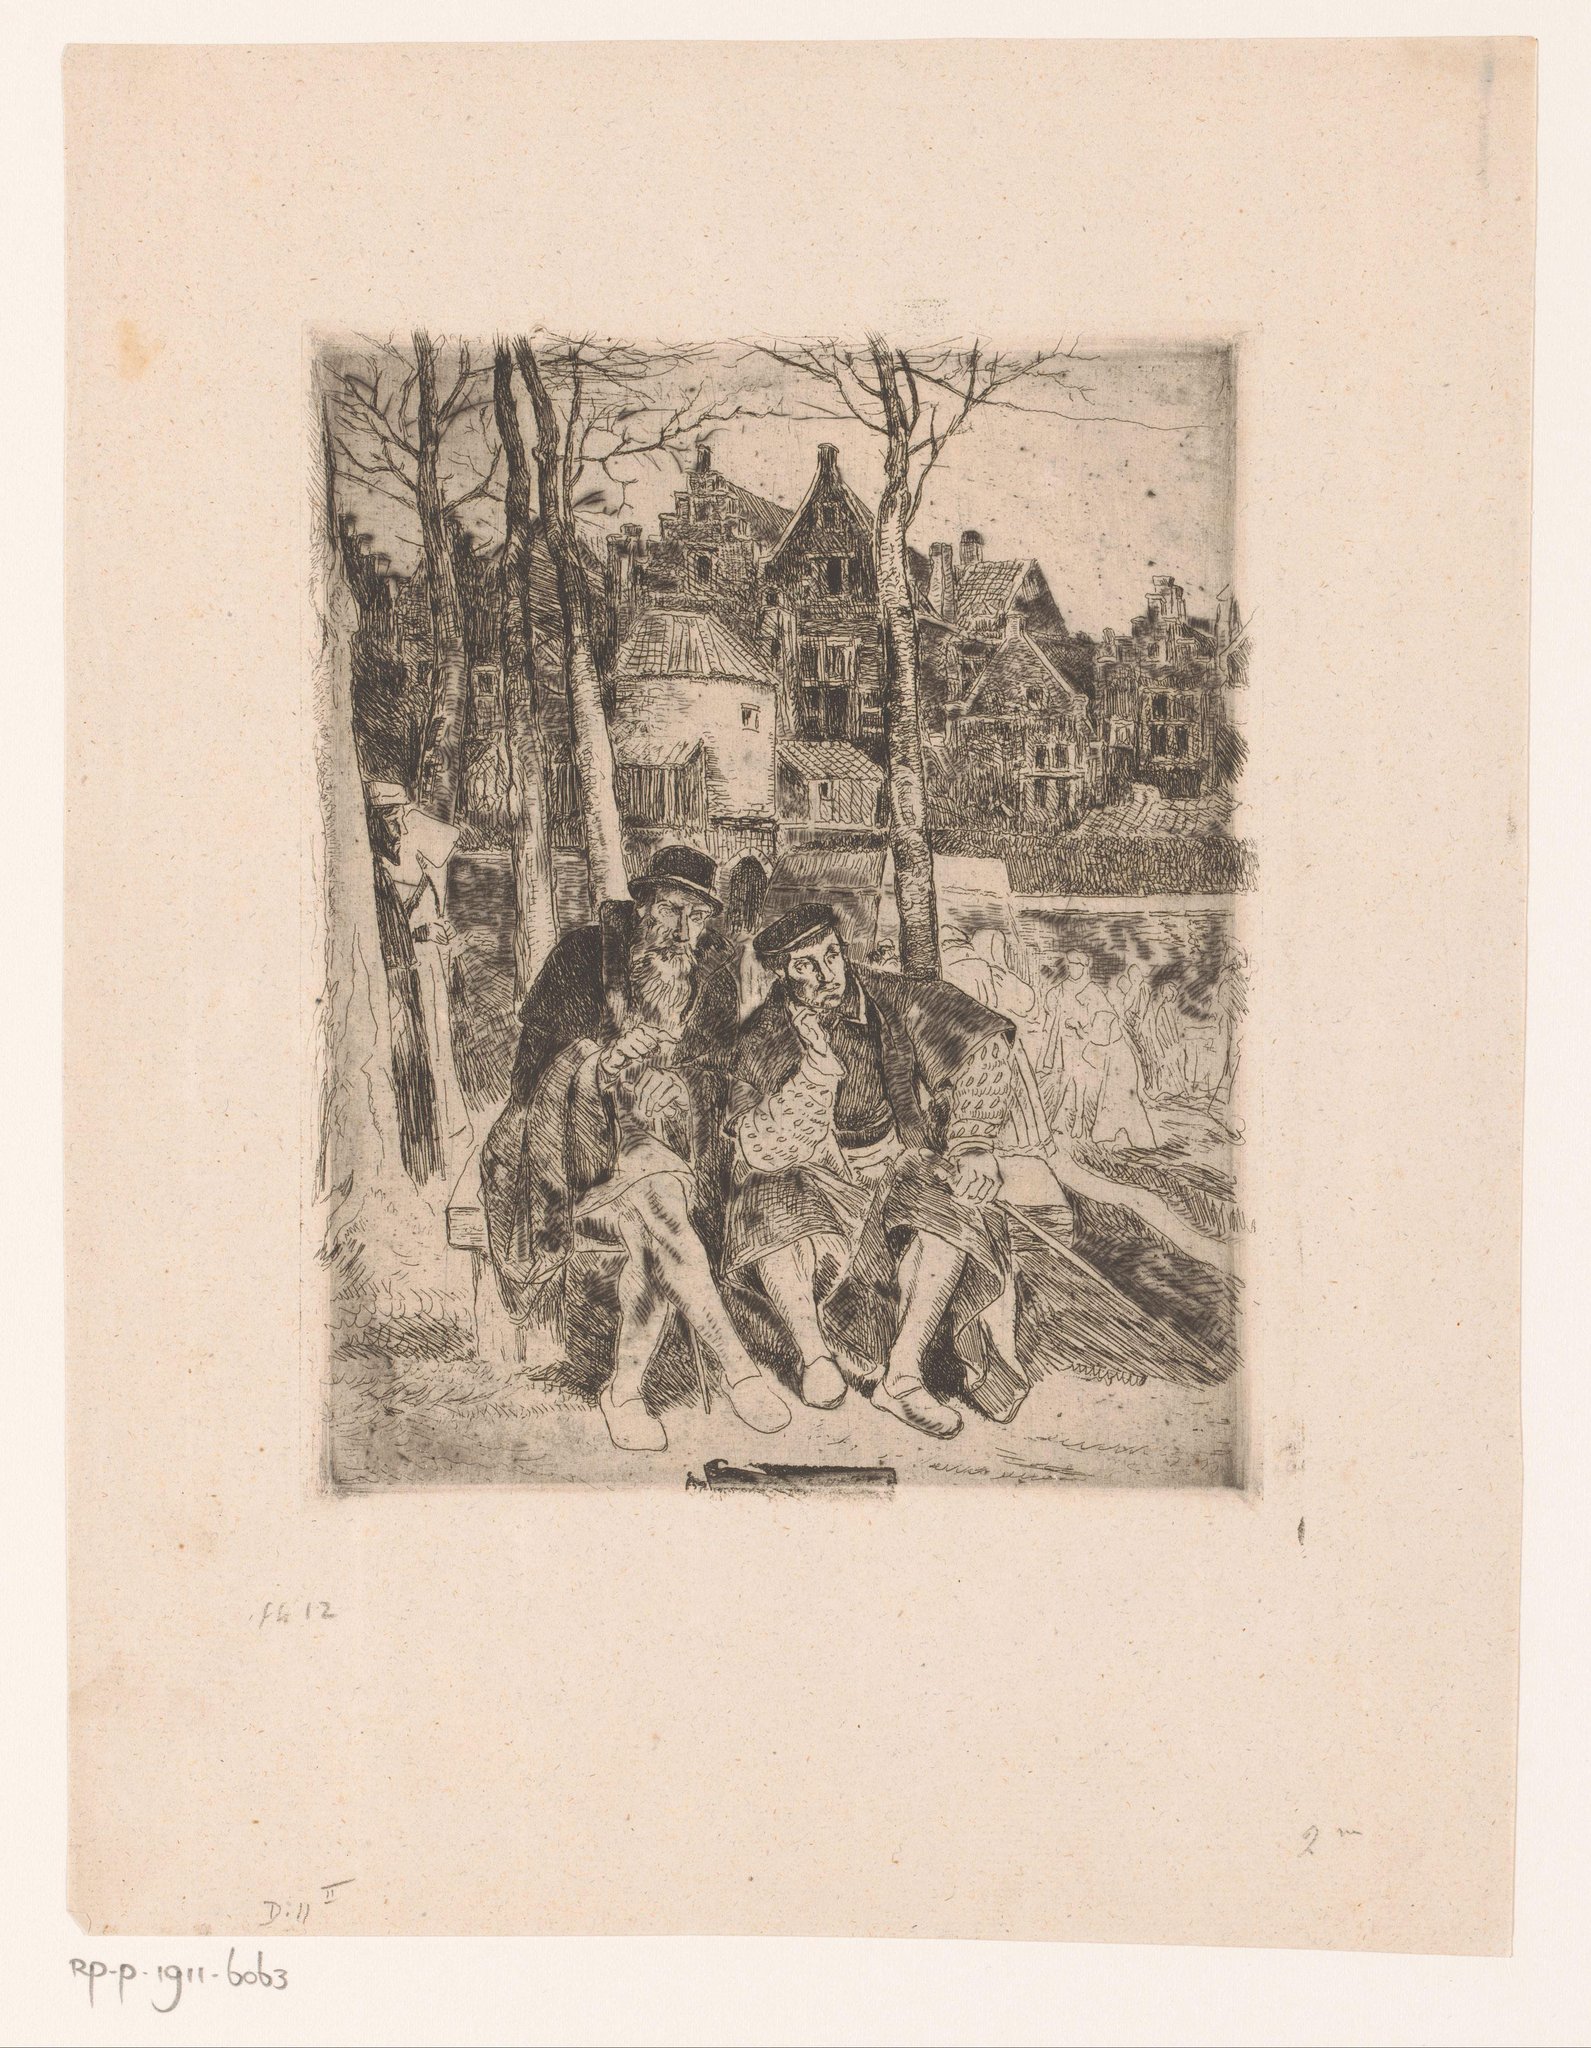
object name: print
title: Twee mannen op een bank buiten de stad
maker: henri leys (baron)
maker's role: draughtsman, painter, print maker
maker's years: 1815-1869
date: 1869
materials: paper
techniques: drypoint, etching, intaglio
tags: bench, prospect of city, town panorama, silhouette of city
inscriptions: collector's mark: Lugt 2228, annotation: ‘2me’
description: Latere staat van deze prent in: Burty, Philippe. Sonnets et eaux-fortes. Paris: Alphonse Lemerre, 1869. Deze ets illustreert daarin het gedicht "Promenade hors des murs" van Théophile Gautier.